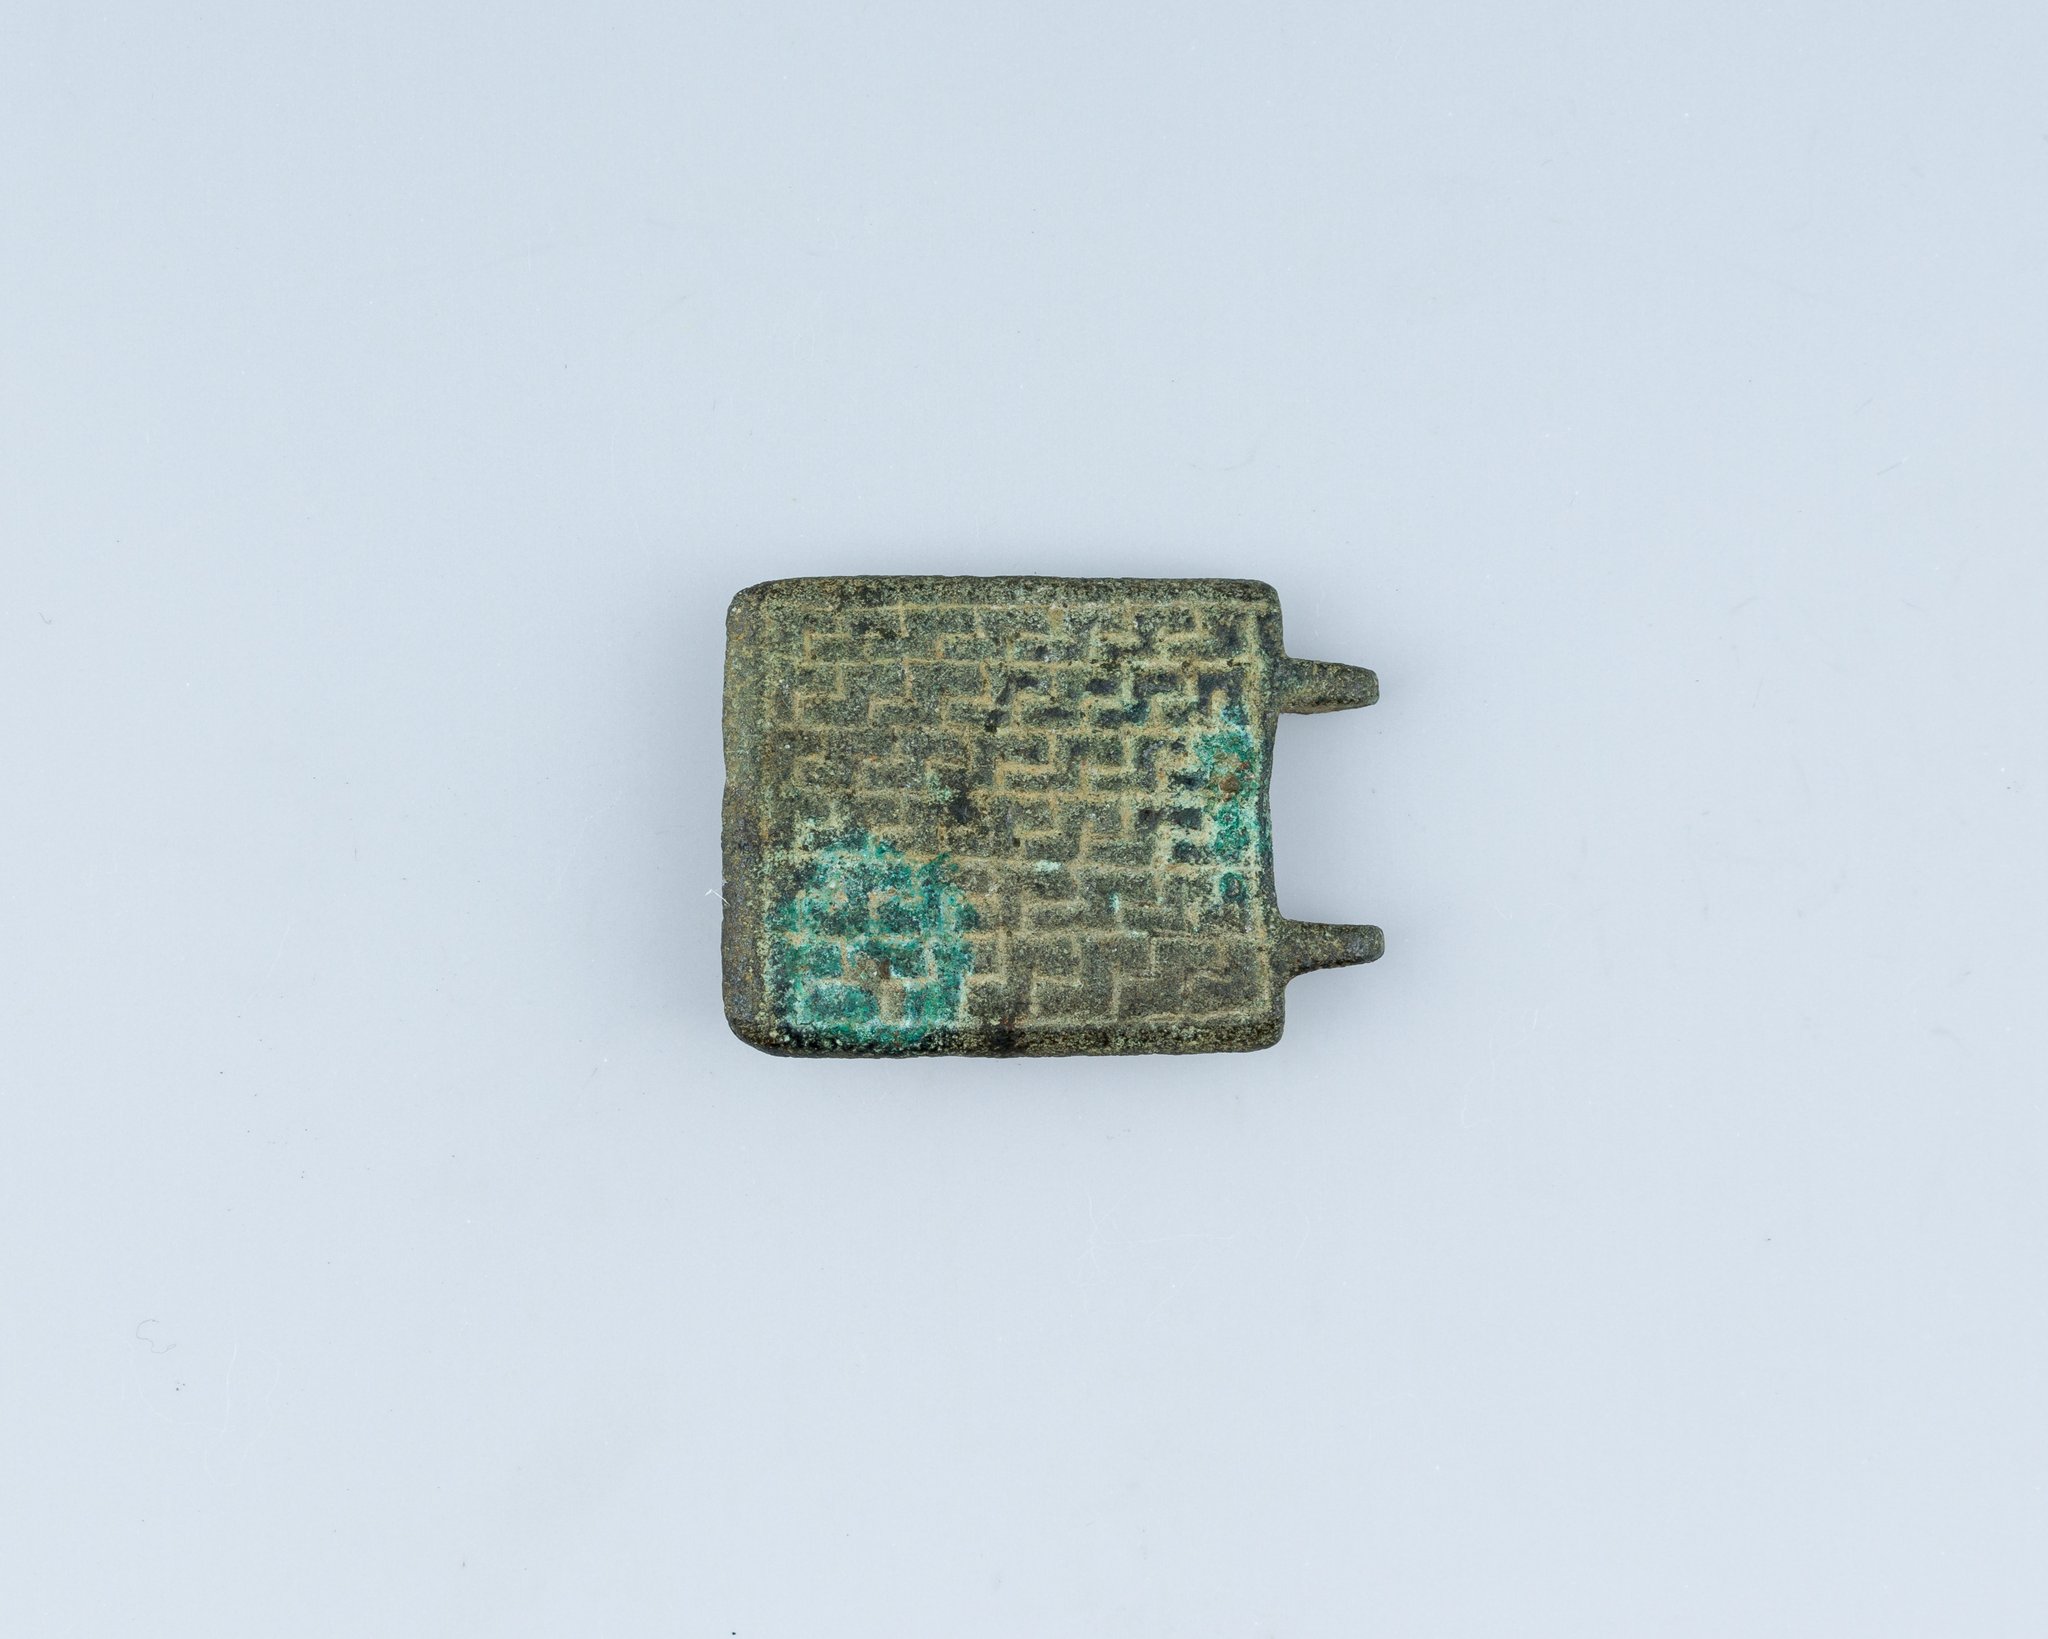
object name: buckle shank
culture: french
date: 1301-1400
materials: bronze, patina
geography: france